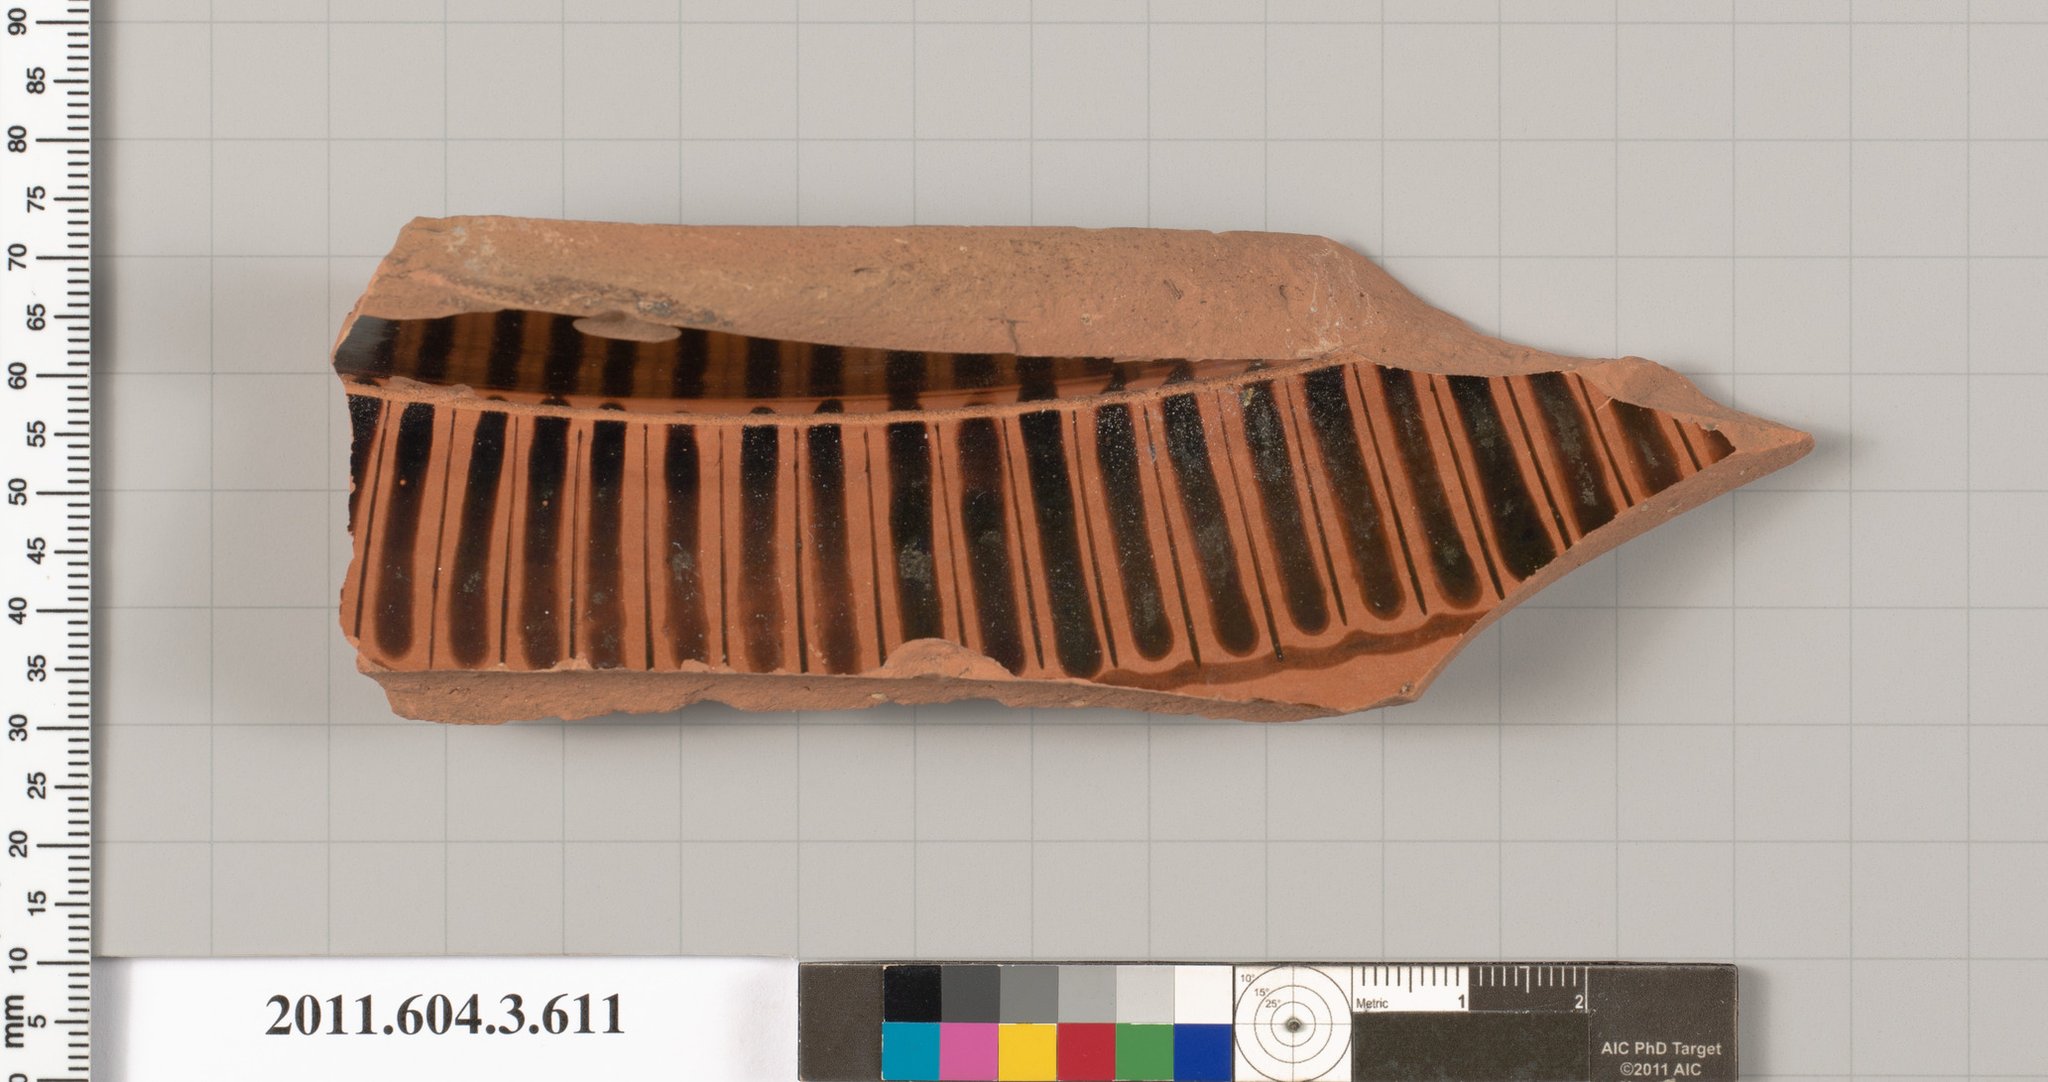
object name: column krater or dinos fragment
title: Terracotta fragment of a column-krater (bowl for mixing wine and water) or dinos (bowl for mixing wine and water)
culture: greek, attic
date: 534-468 BCE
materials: terracotta